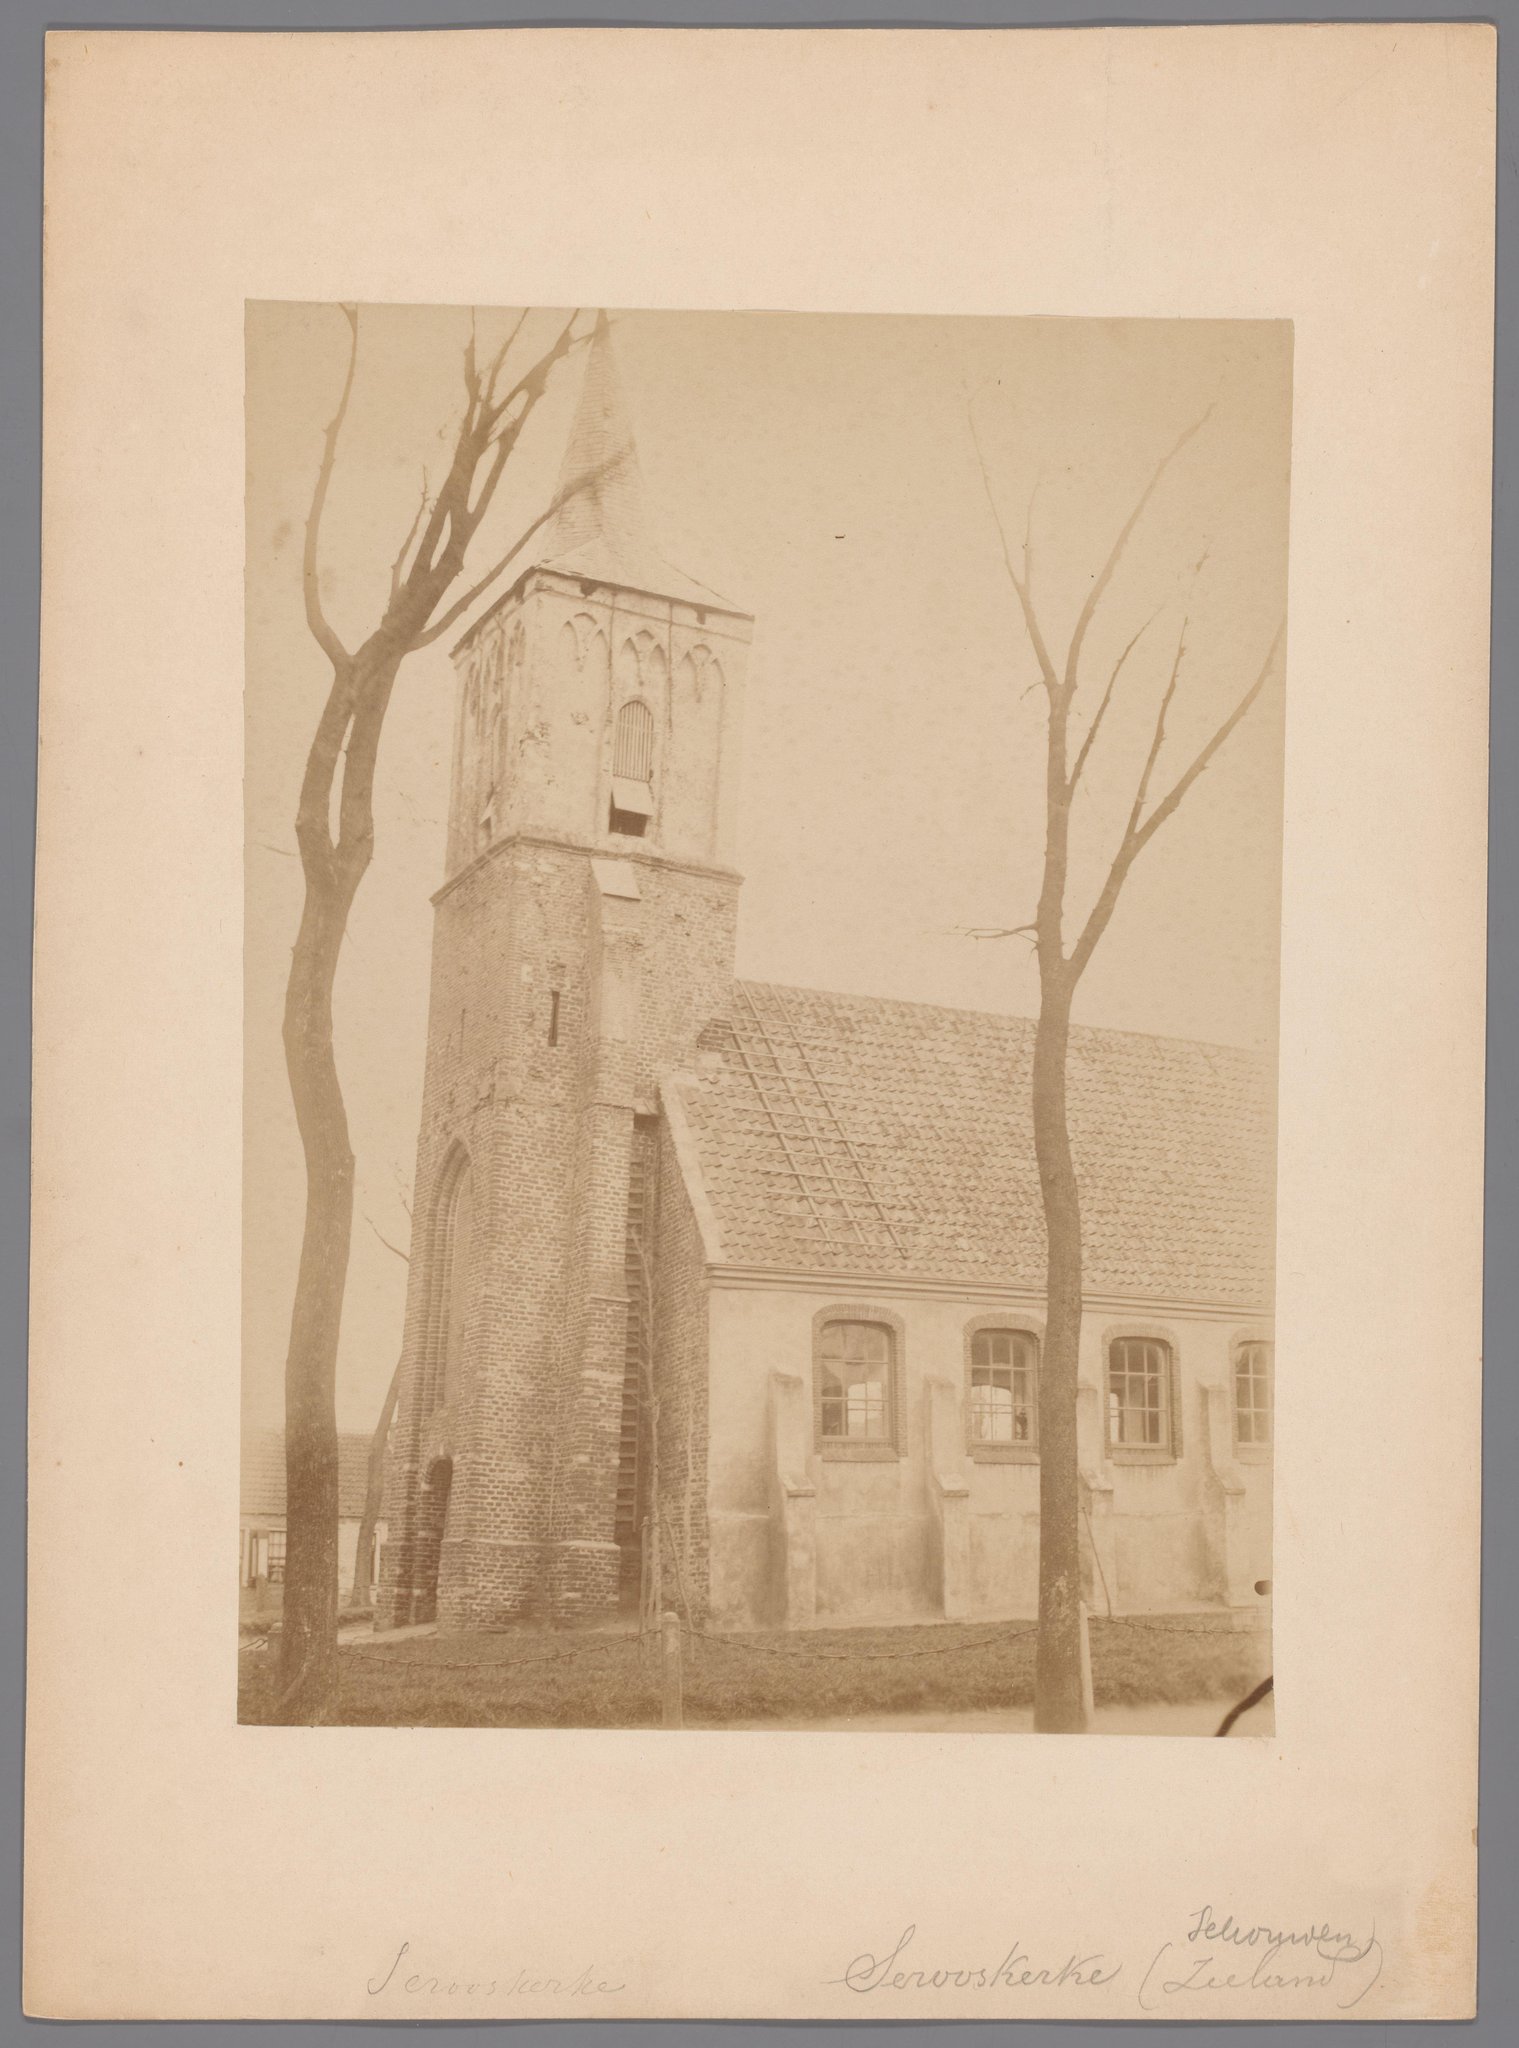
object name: photograph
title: Gezicht op de Hervormde Kerk te Serooskerke op Schouwen-Duiveland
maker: anoniem (monumentenzorg)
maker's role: fotograaf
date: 1893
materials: cardboard, photographic support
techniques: albumen print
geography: serooskerke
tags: church (exterior)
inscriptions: annotation: ‘Serooskerke Schouwen (Zeeland)’, annotation: ‘Serooskerke op het eiland Schouwen/ Zeeland/ Zuid-westzijde van de kerk en den toren/ Maart 1983’